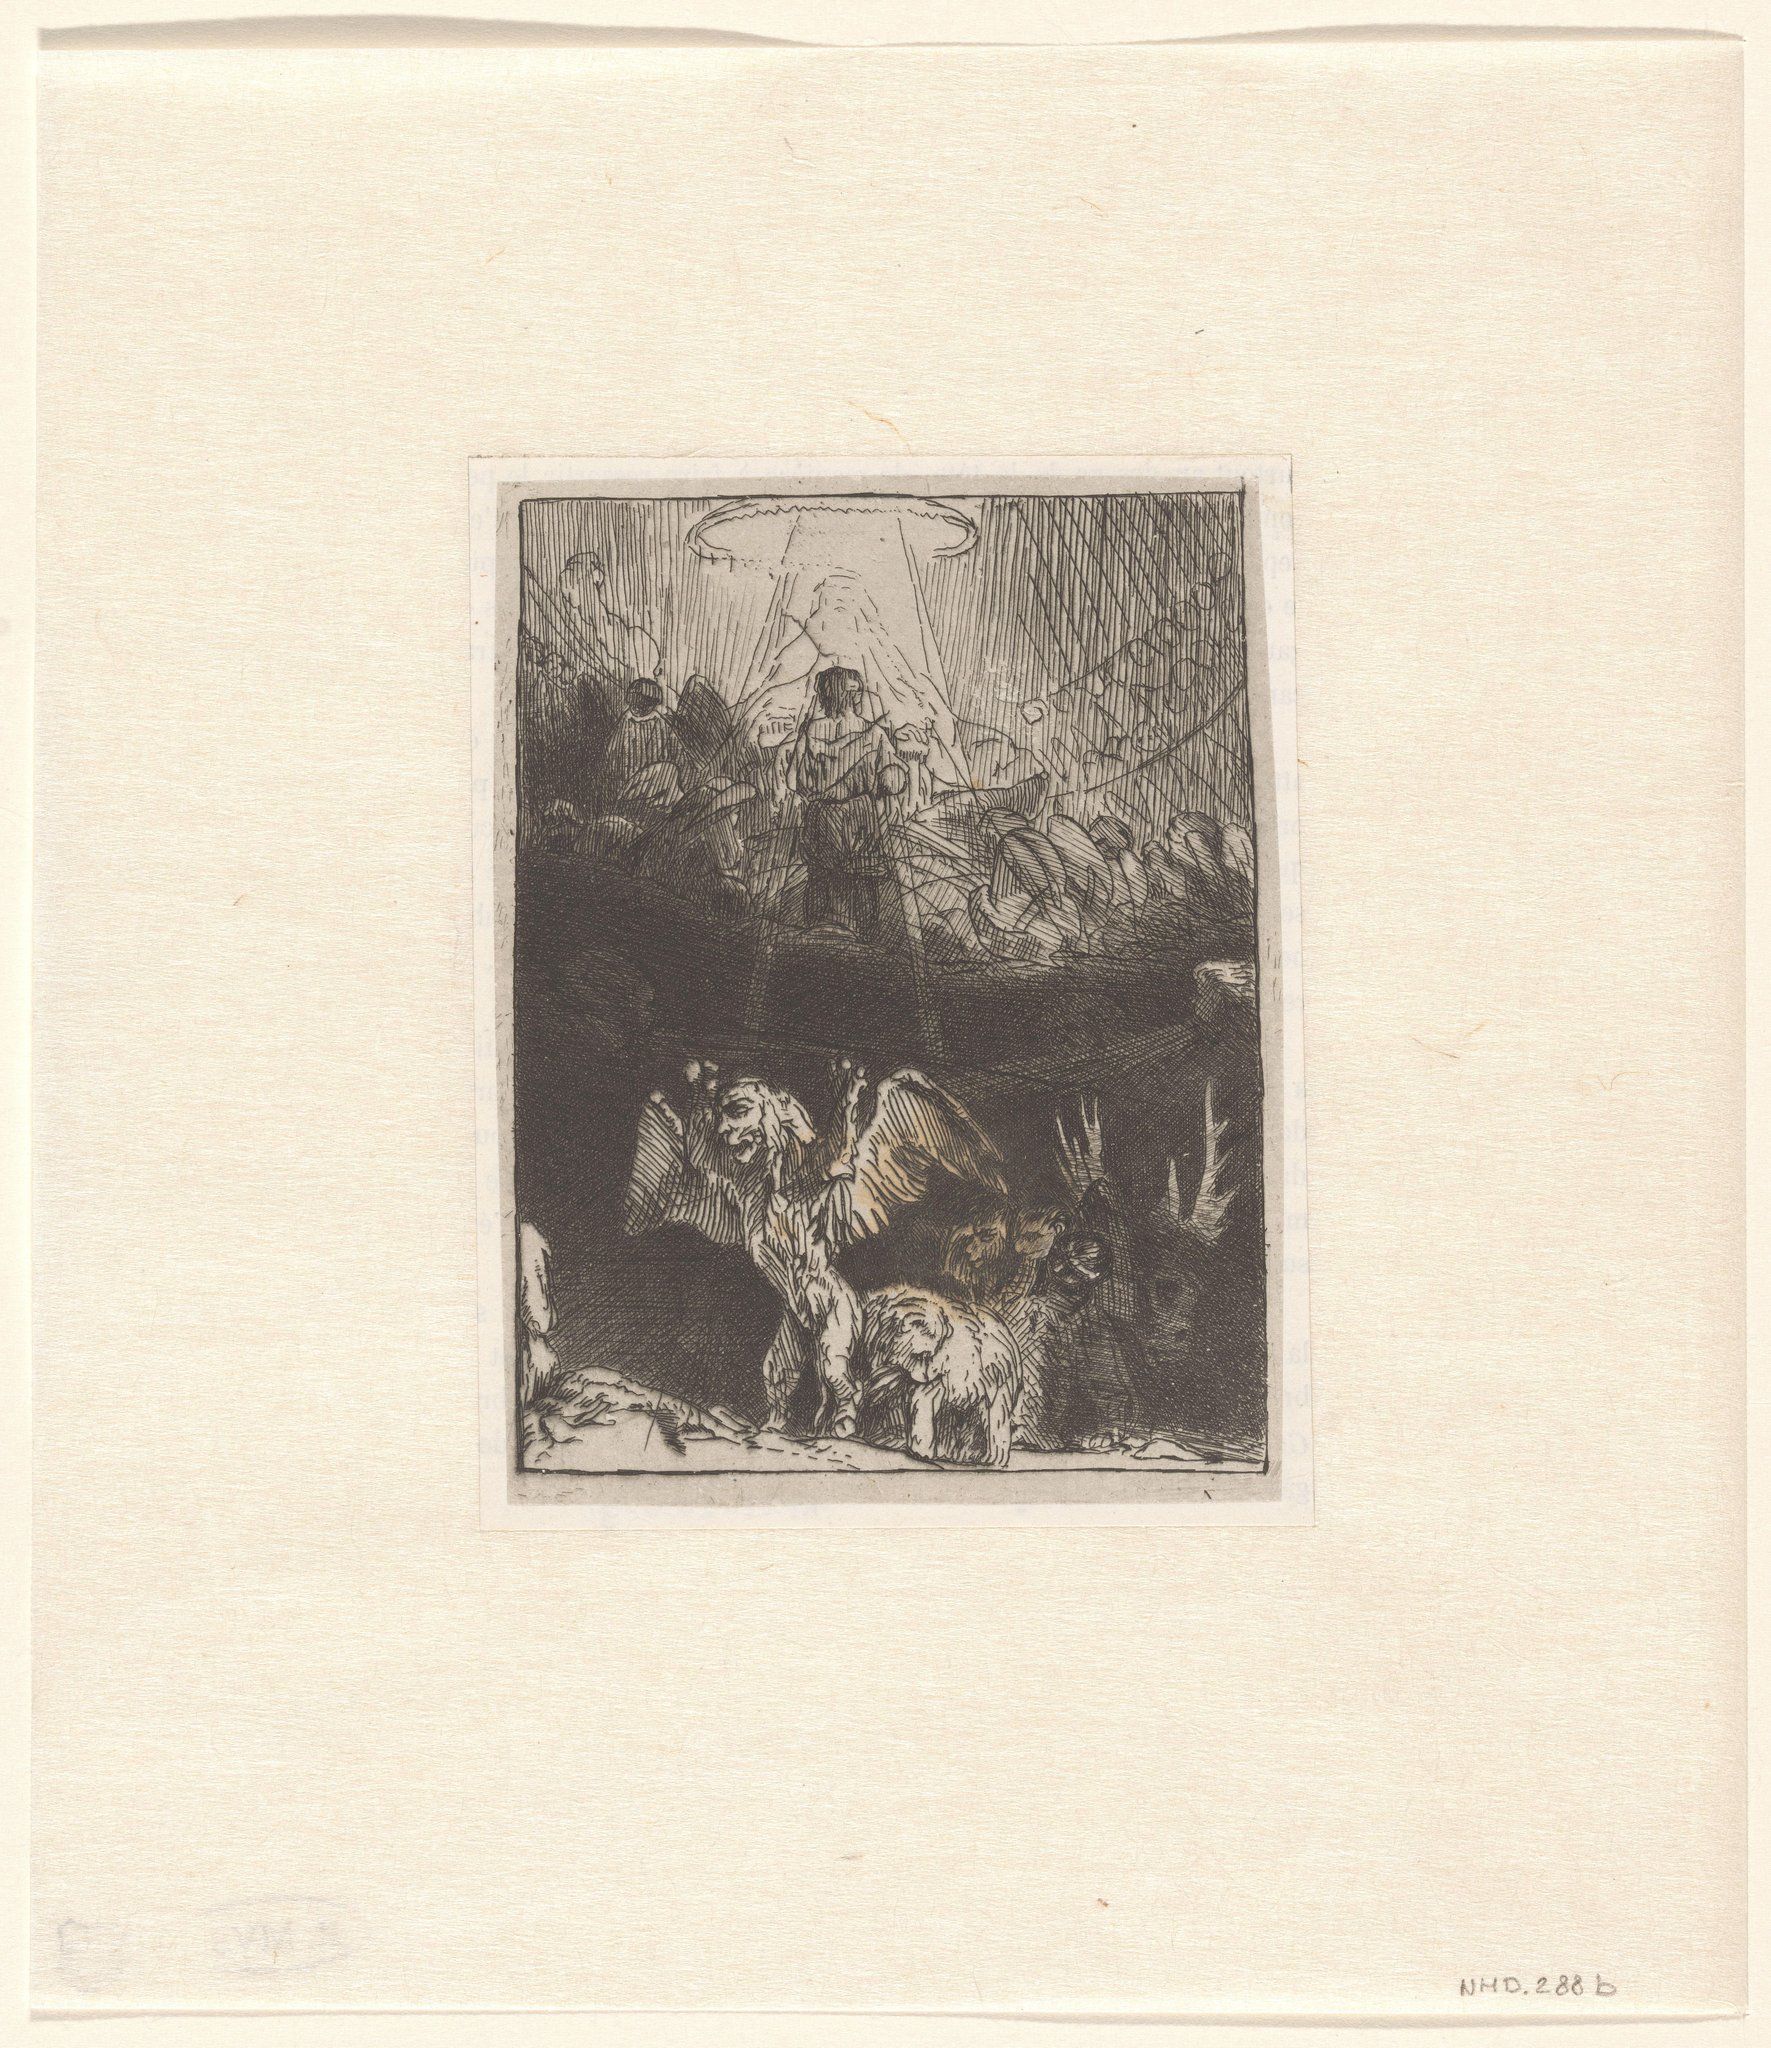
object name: print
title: Daniel’s vision of four beasts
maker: léopold flameng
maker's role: print maker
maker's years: 1831-1911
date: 1859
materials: paper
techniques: etching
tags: daniel's visions (daniel may be shown having his visions explained, e.g. by the archangel gabriel)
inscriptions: collector's mark: Lugt 2760, collector's mark: Lugt 2228